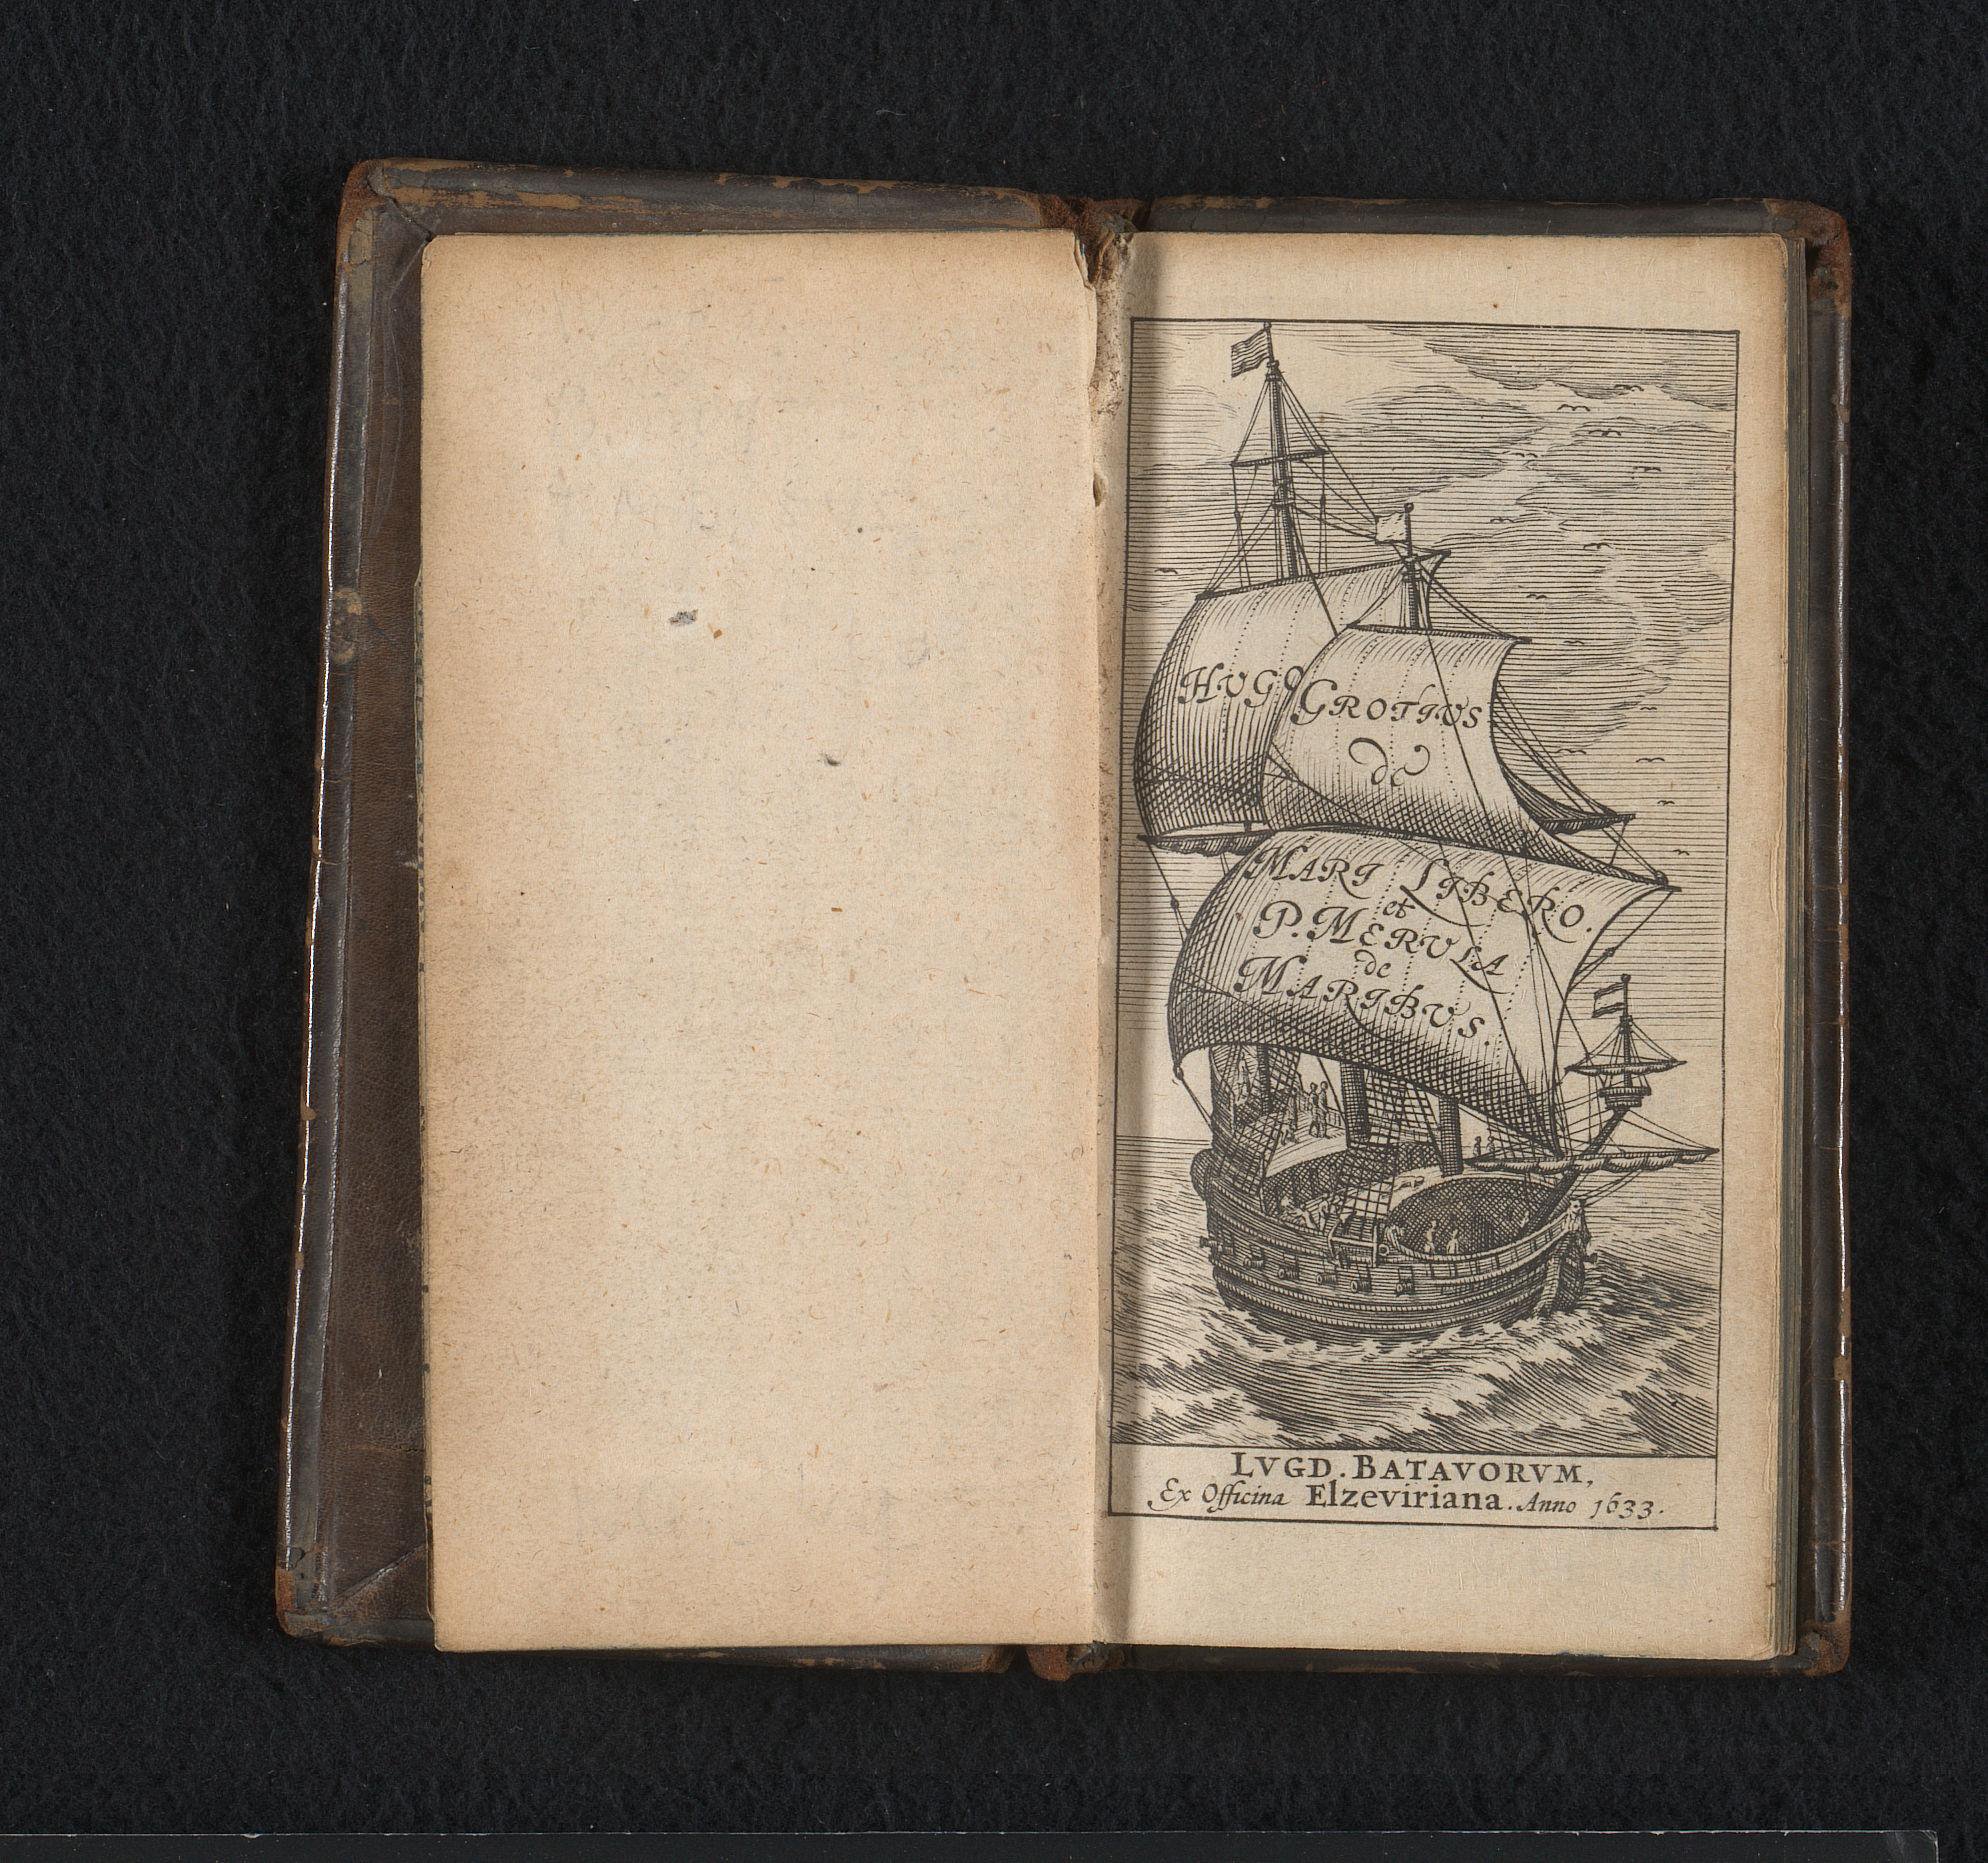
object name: book illustration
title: De mari libero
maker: Anonymous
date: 1633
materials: paper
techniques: engraving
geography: leiden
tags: sailing-ship, sailing-boat, title-page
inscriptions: date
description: Titelpagina voor: Groot, Hugo de, en Paulus Merula. Hugo Grotius de mare libero et P. Merula de maribus. Lugduni Batavorum [=Leiden]: Ex officina Elzeviriana, 1633.